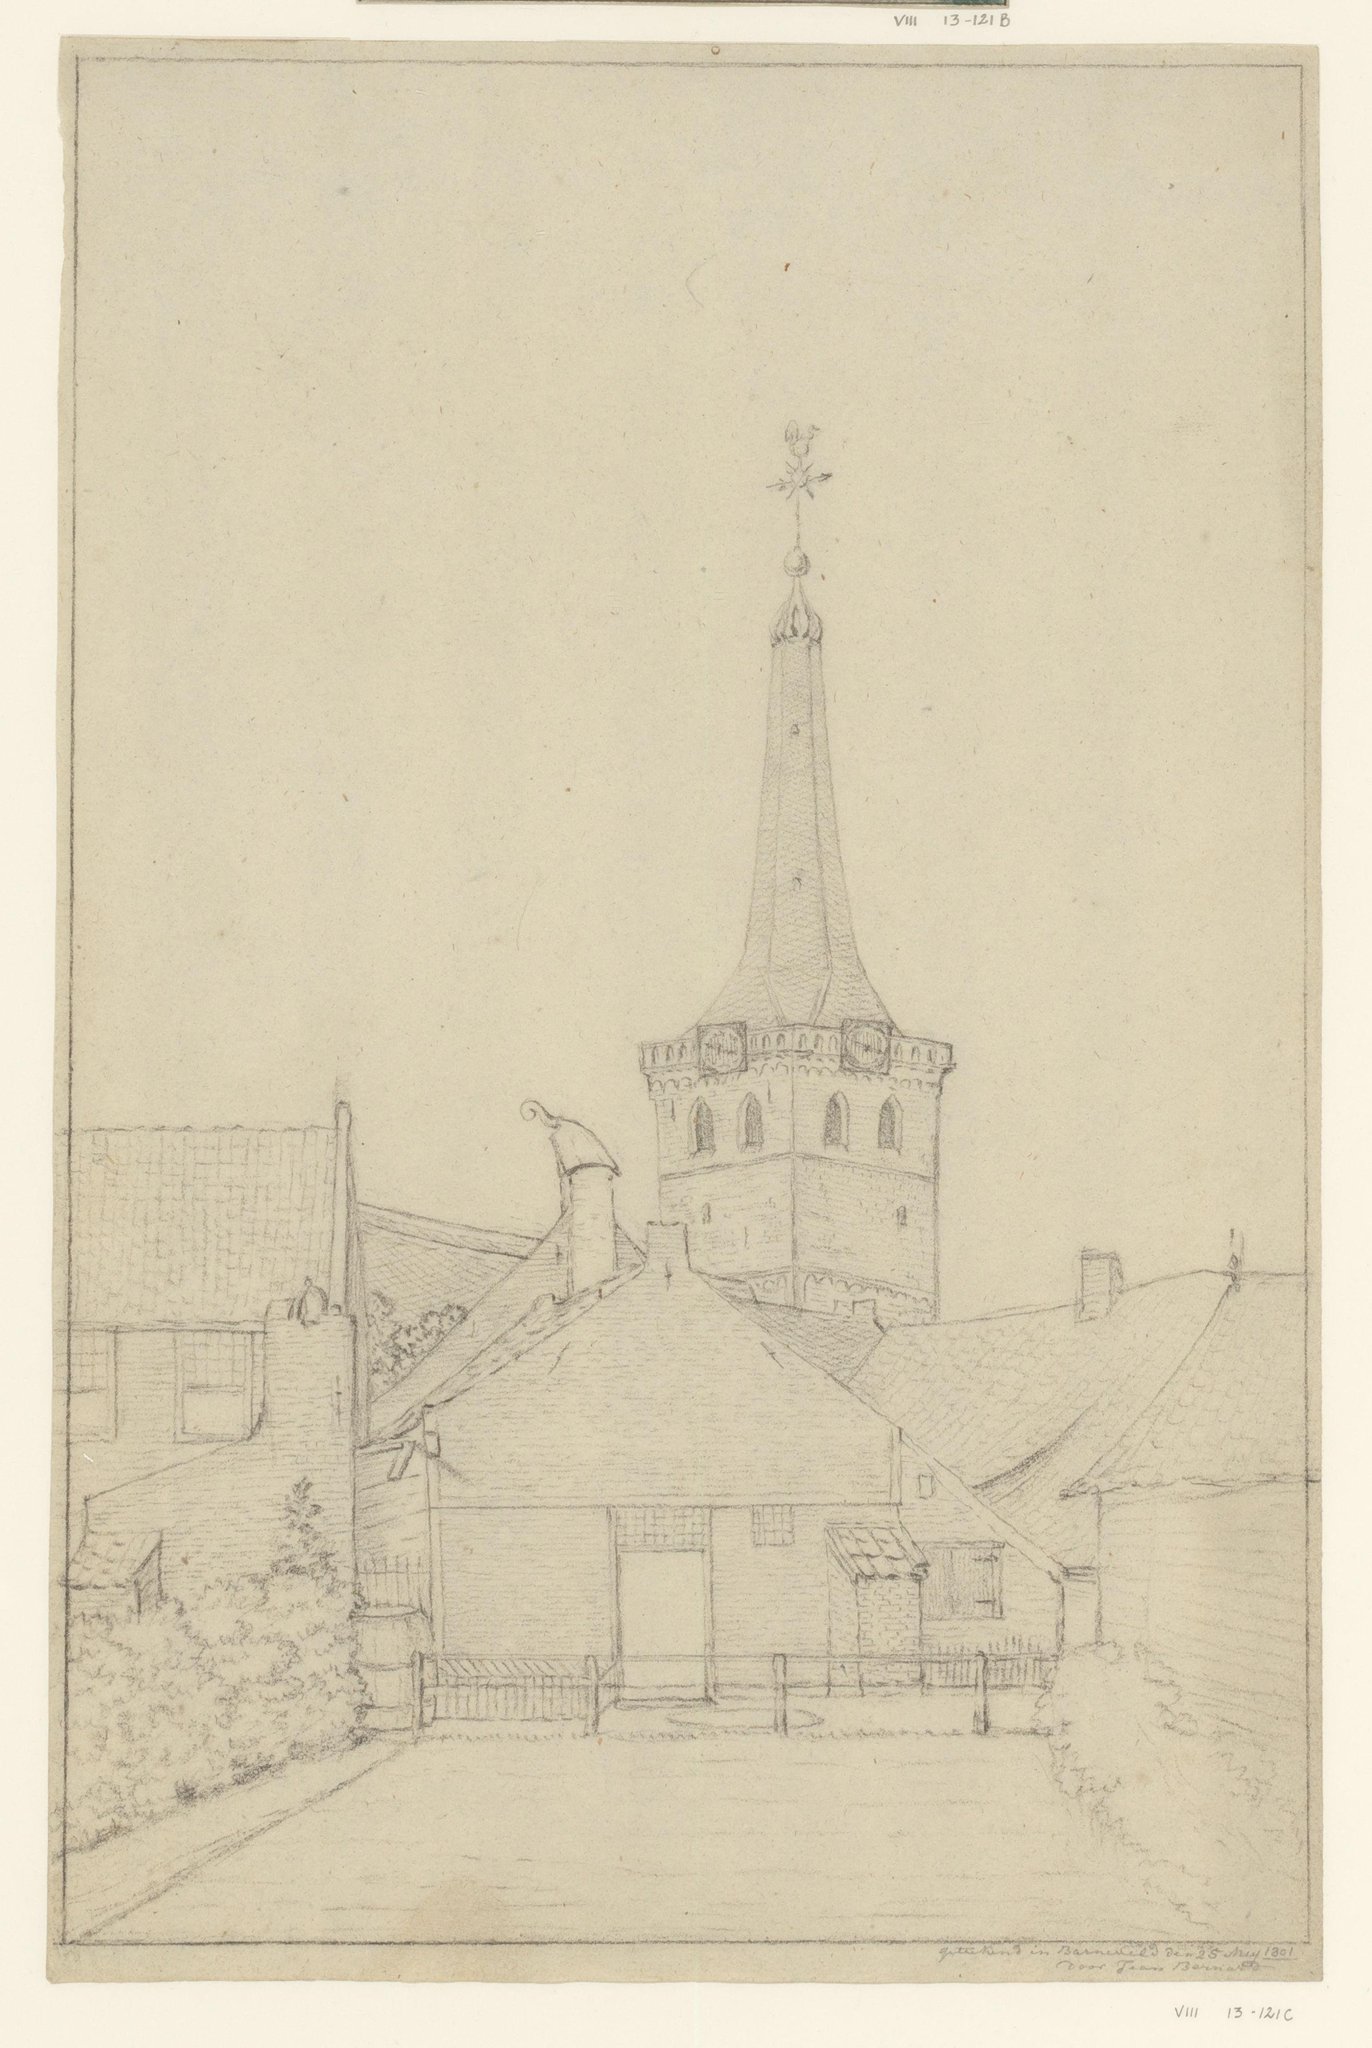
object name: drawing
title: Oude Kerk te Barneveld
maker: jean bernard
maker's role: draughtsman, print maker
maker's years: 1765-1833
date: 1801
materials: paper, pencil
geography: netherlands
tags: garden, village, church (exterior), backyard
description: Gezicht over enkele huizen en een tuin op de Oude Kerk te Barneveld. Onderwerpsrubrieken binnen de Atlas Zeden en Gewoonten: Kerk en kerkwezen & Armwezen en liefdadige instellingen; Kerkgebouwen elders. A-E.